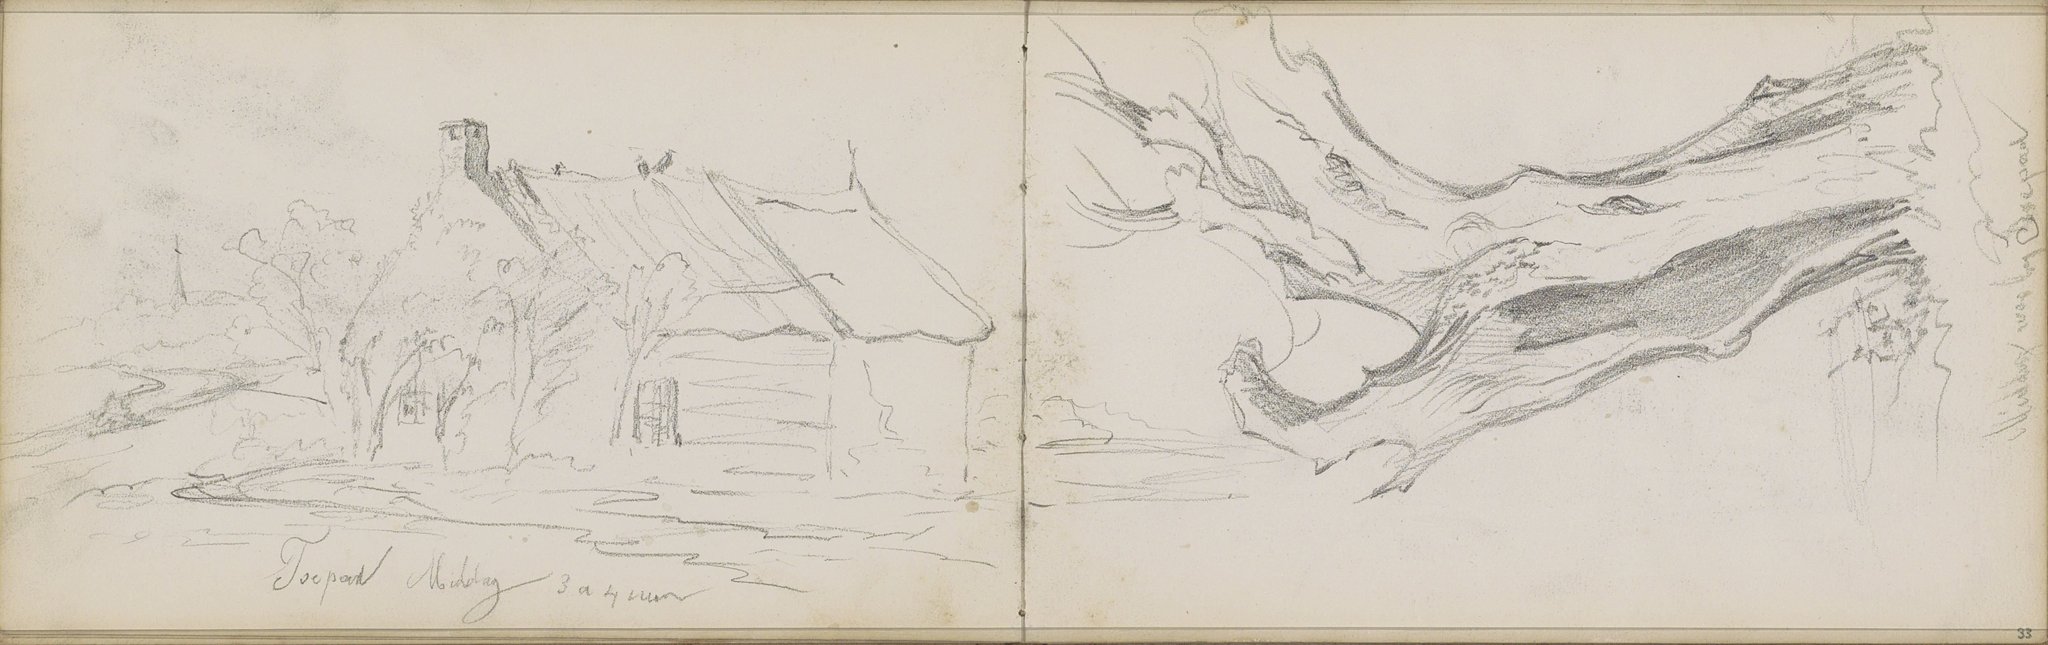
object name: sketchbook leaf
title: Toepad bij een arbeiderswoning en een boom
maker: willem cornelis rip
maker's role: draughtsman, painter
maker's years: 1856-1922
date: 1874-1875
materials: paper, pencil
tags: road, path, cottage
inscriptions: annotation: ‘Toepad Middag 3 a 4 uur/ Middag voor bij [...]epad’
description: Blad 32 verso en 33 recto uit een schetsboek met 46 bladen.